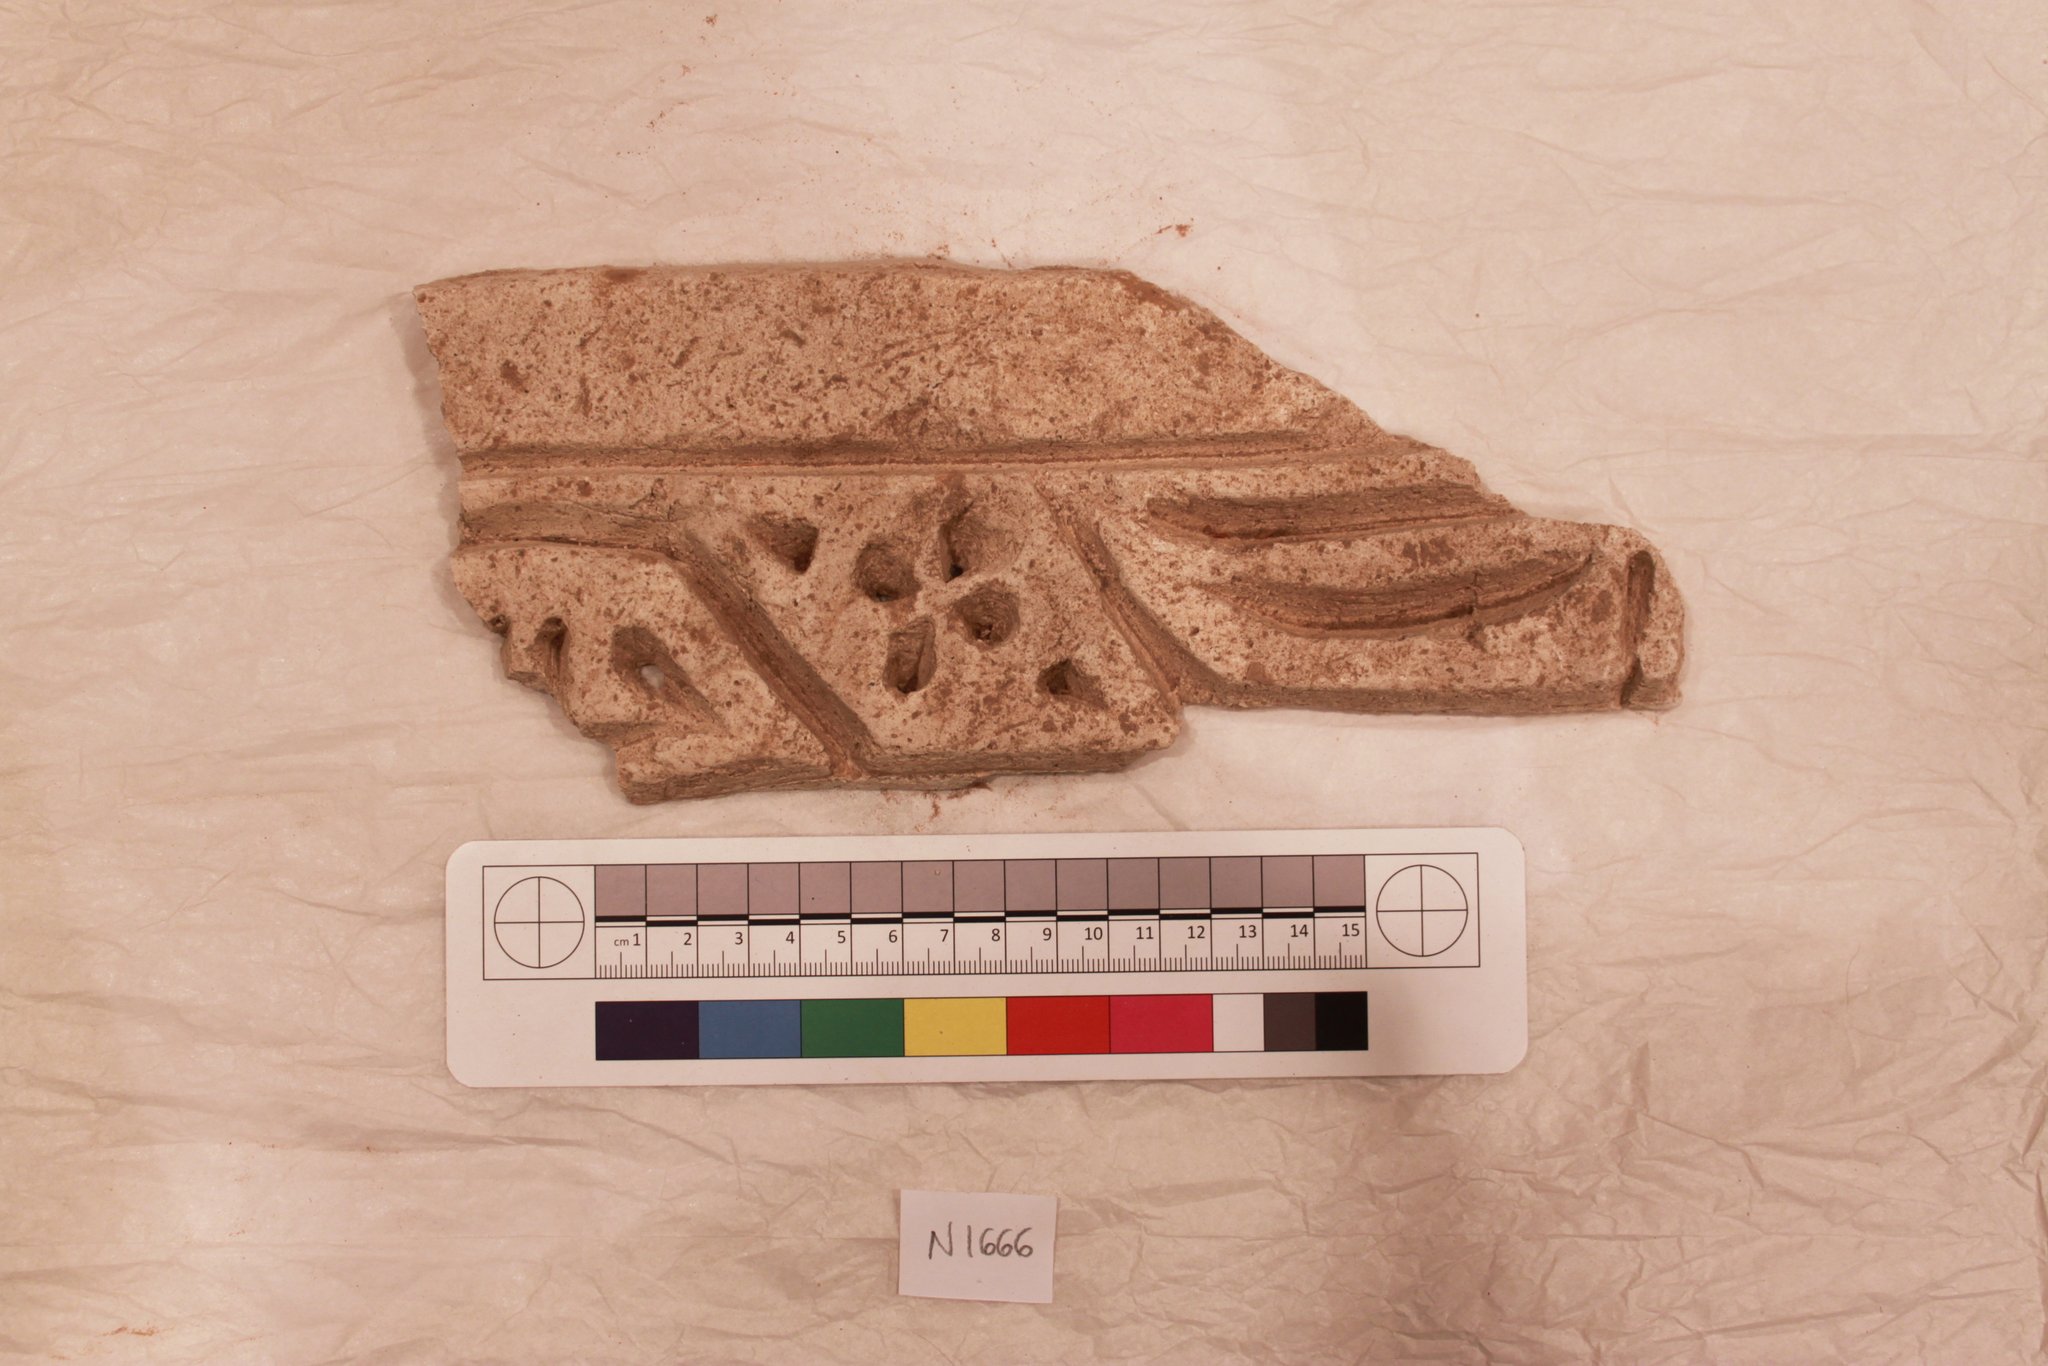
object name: fragment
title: Stucco Fragment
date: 701-1200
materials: plaster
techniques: carving, painting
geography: iran